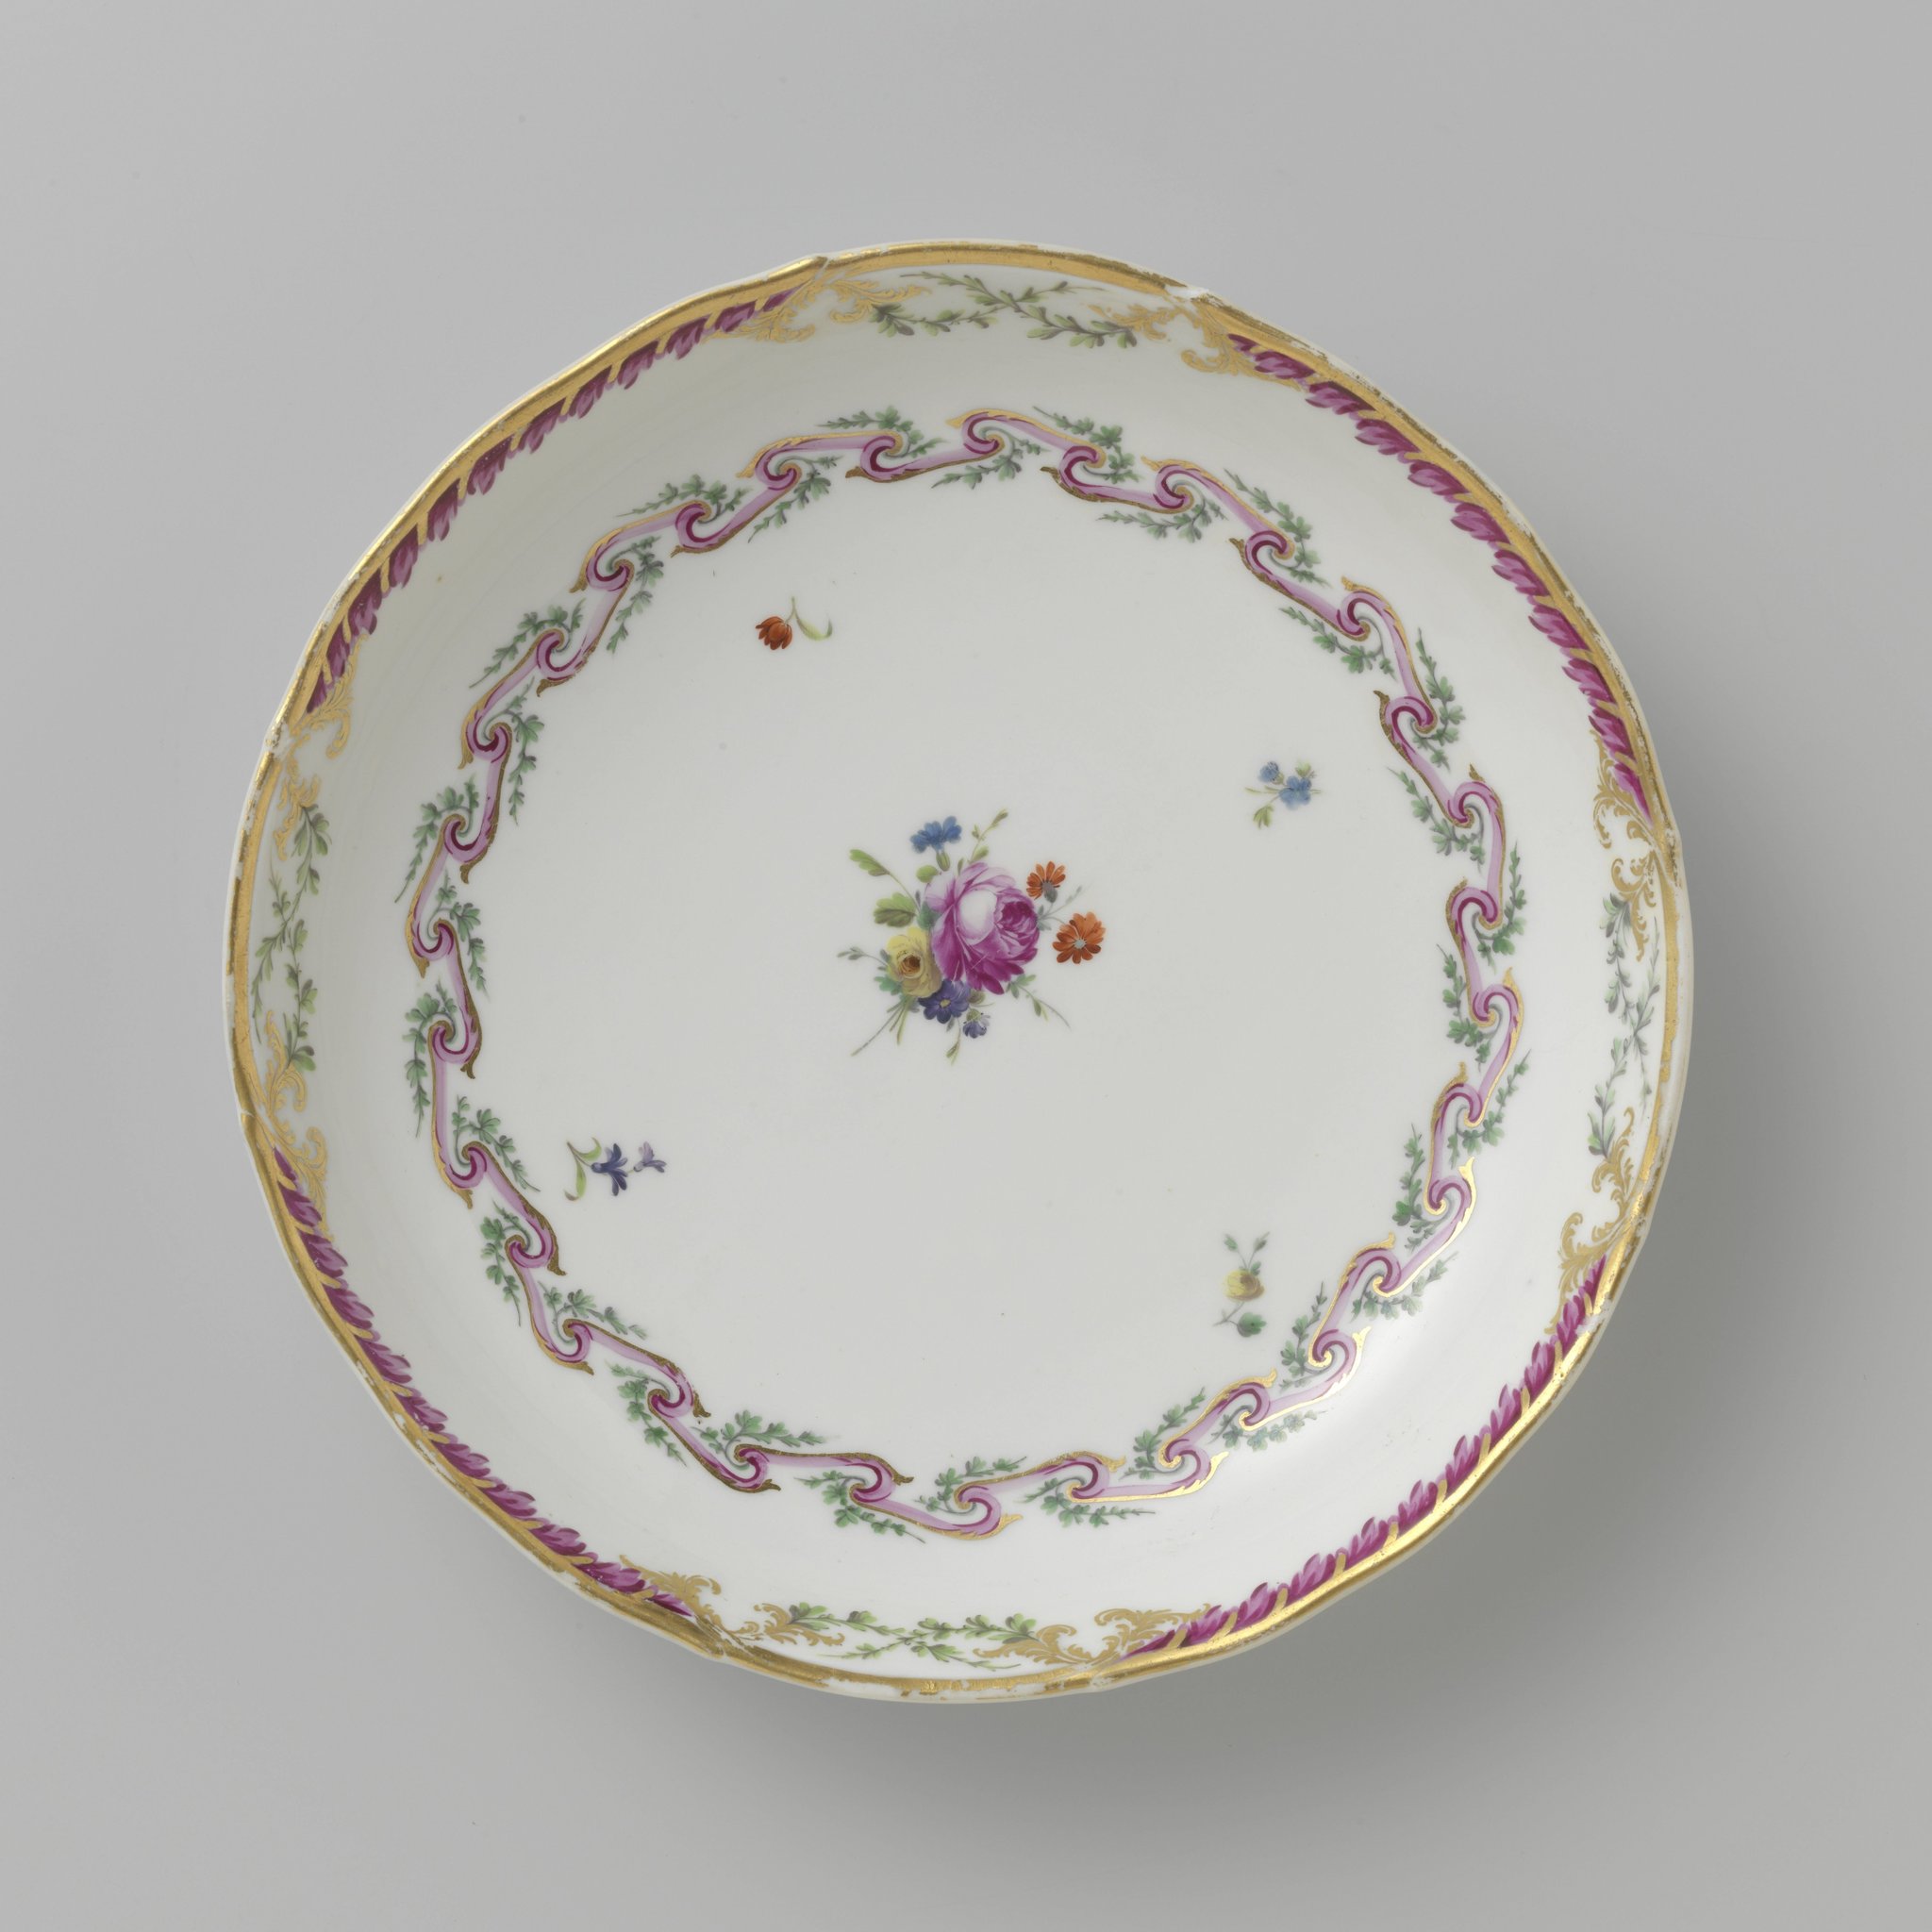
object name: dish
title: Schaal, rond en diep, behorend bij een servies versierd met geslingerd lintmotief met bladertakken, bloemboeketten en gestrooide bloemtakken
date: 1780-1820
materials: porcelain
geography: loosdrecht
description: Schaal, rond en diep , behorend bij een servies van porselein versierd met een geslingerd lintmotief in paars en goud met groene bladertakken, bloemboeketten en gestrooide bloemtakken. Randen licht gegolfd, met decoratie in goud met paars bladmotief waartussen groen gekruist bladmotief. Gemerkt: M.O.L. en Amstel.